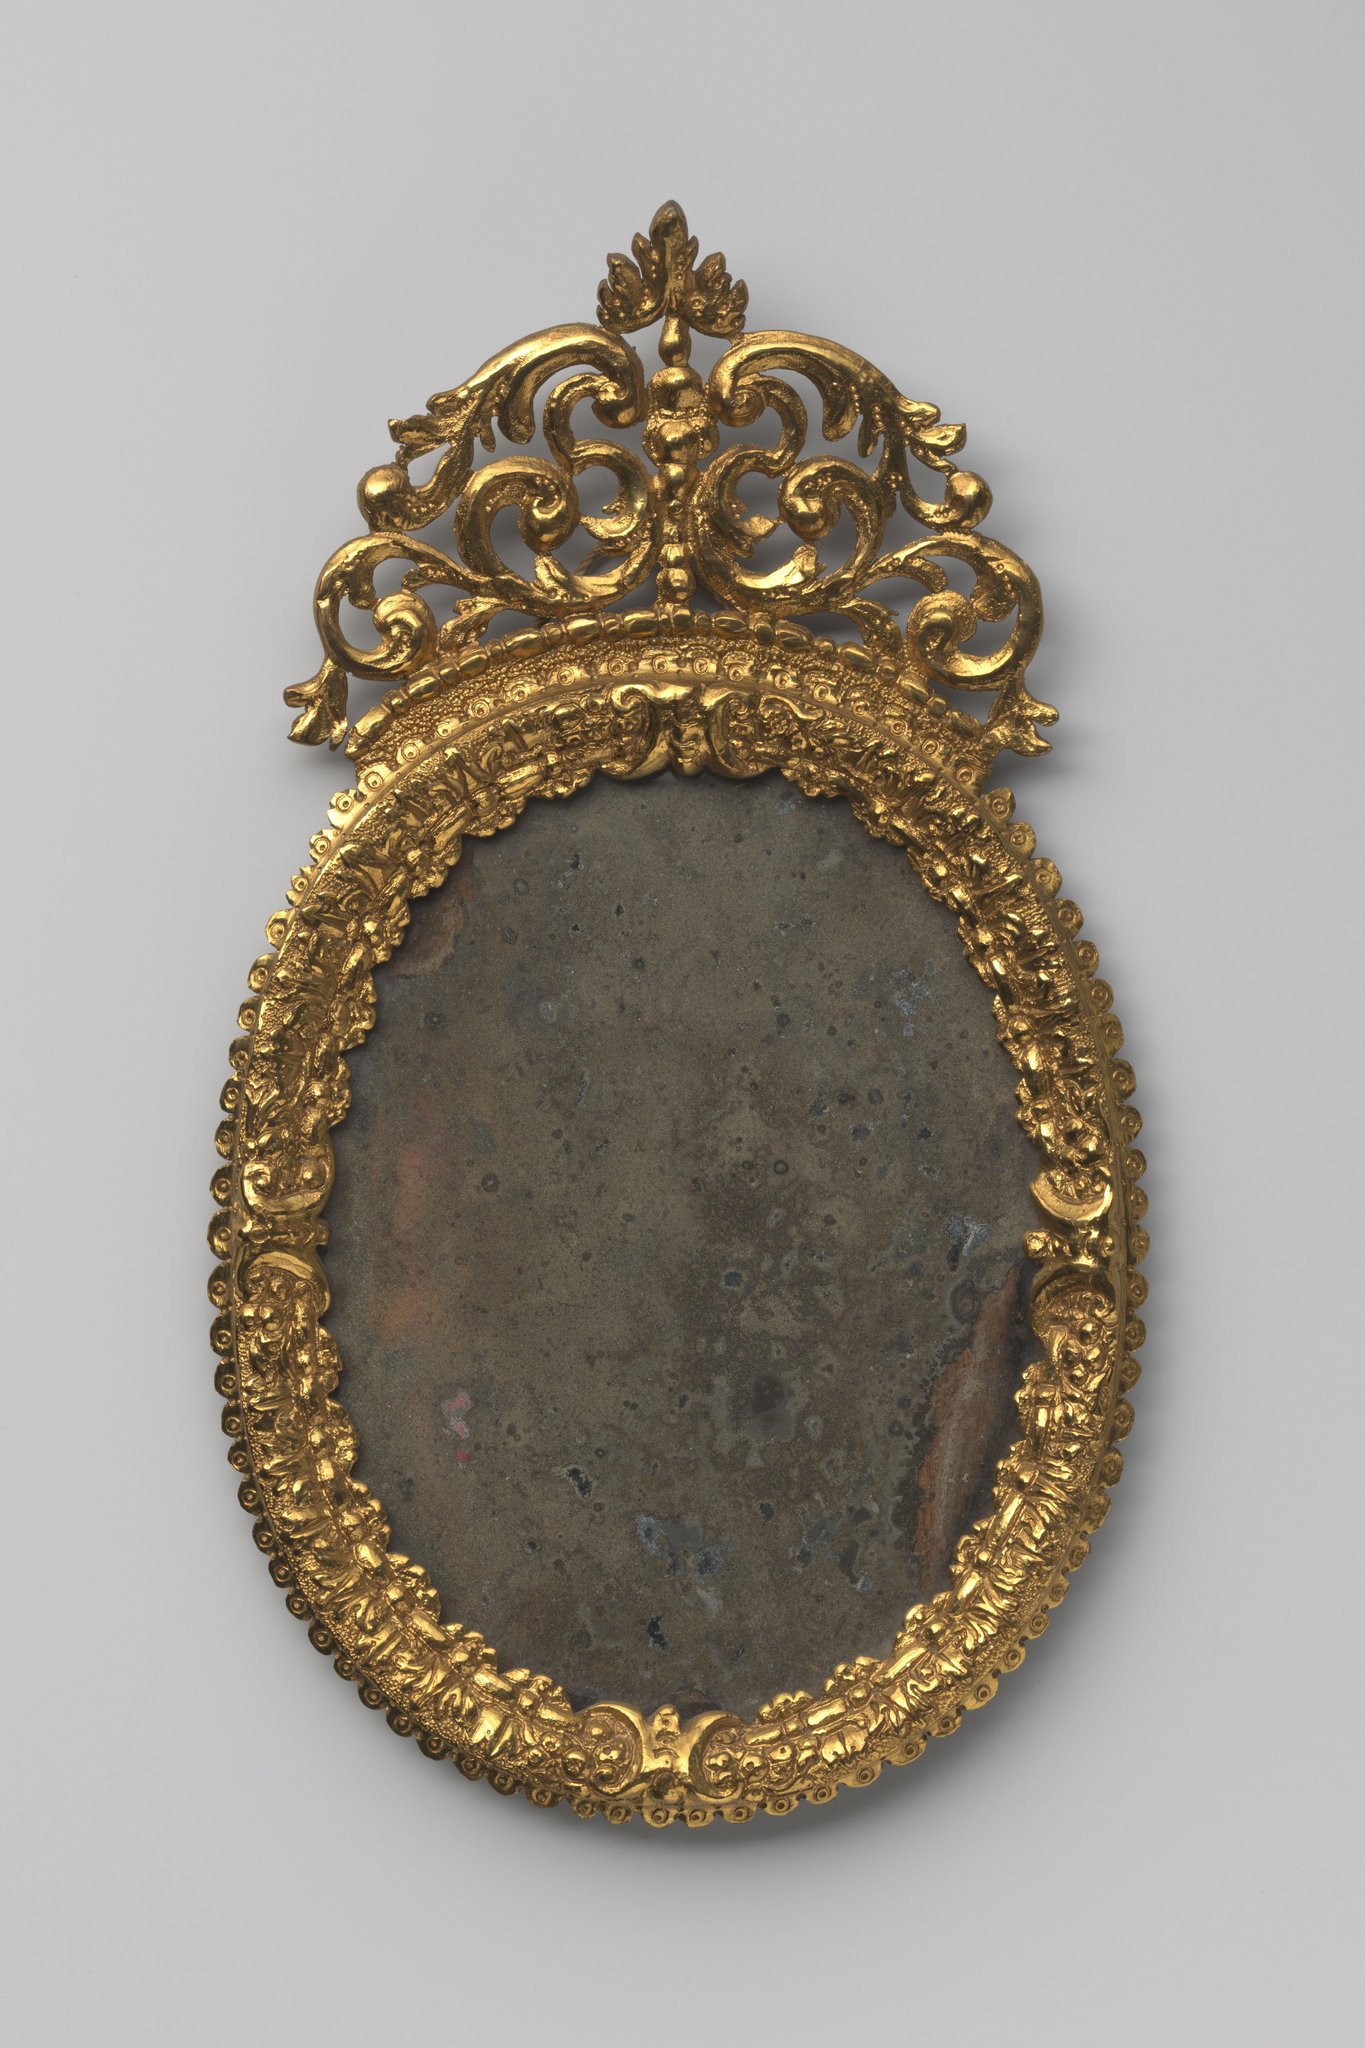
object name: miniature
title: Ovale spiegel in een verguld bronzen lijst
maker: Anonymous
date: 1690-1710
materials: amalgam, bronze, glass, wood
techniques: gilding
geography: amsterdam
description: Ovale spiegel in verguld geornamenteerd bronzen lijst, versierd met schulpen, gestileerde acanthusblad motieven op gespikkelde achtergrond, onderbroken parelrand, en dubbele voluten op de vier middens van de bogen. De lijst wordt bekroond door een ornament van symmetrisch gegroepeerde bladranken. In de lijst het originele sterk gecorrodeerde speigelglas met geslepen facetrand, aan de achterzijde afgesloten door een houten paneel en twee latjes.